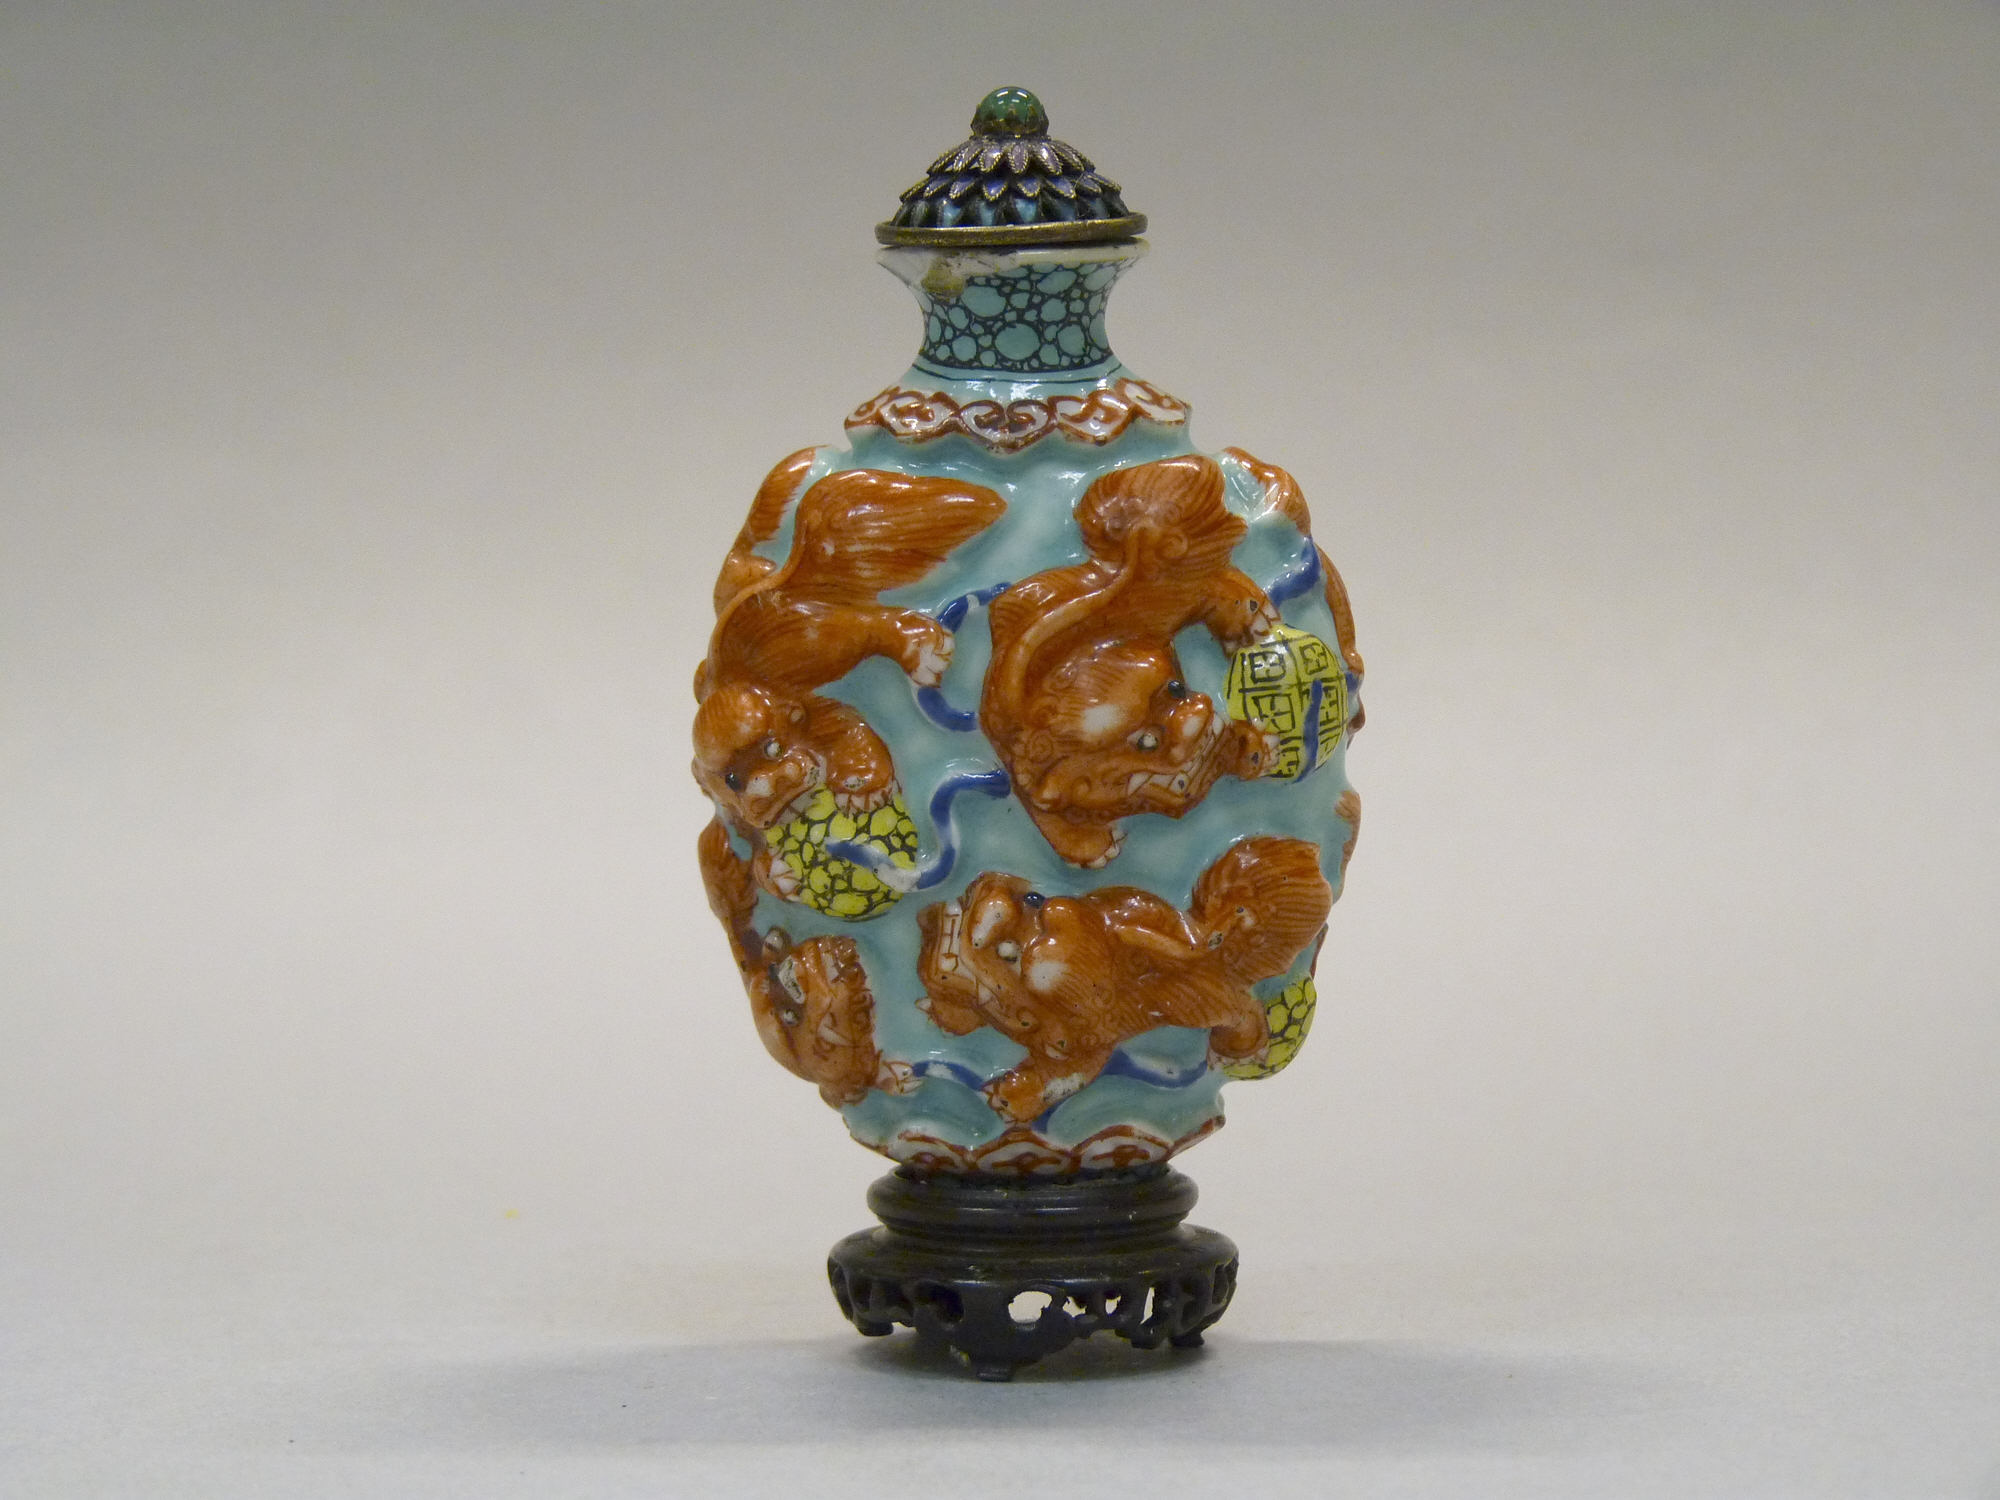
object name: snuff bottle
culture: chinese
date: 1736-1795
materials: metal, porcelain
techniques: enamel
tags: lions